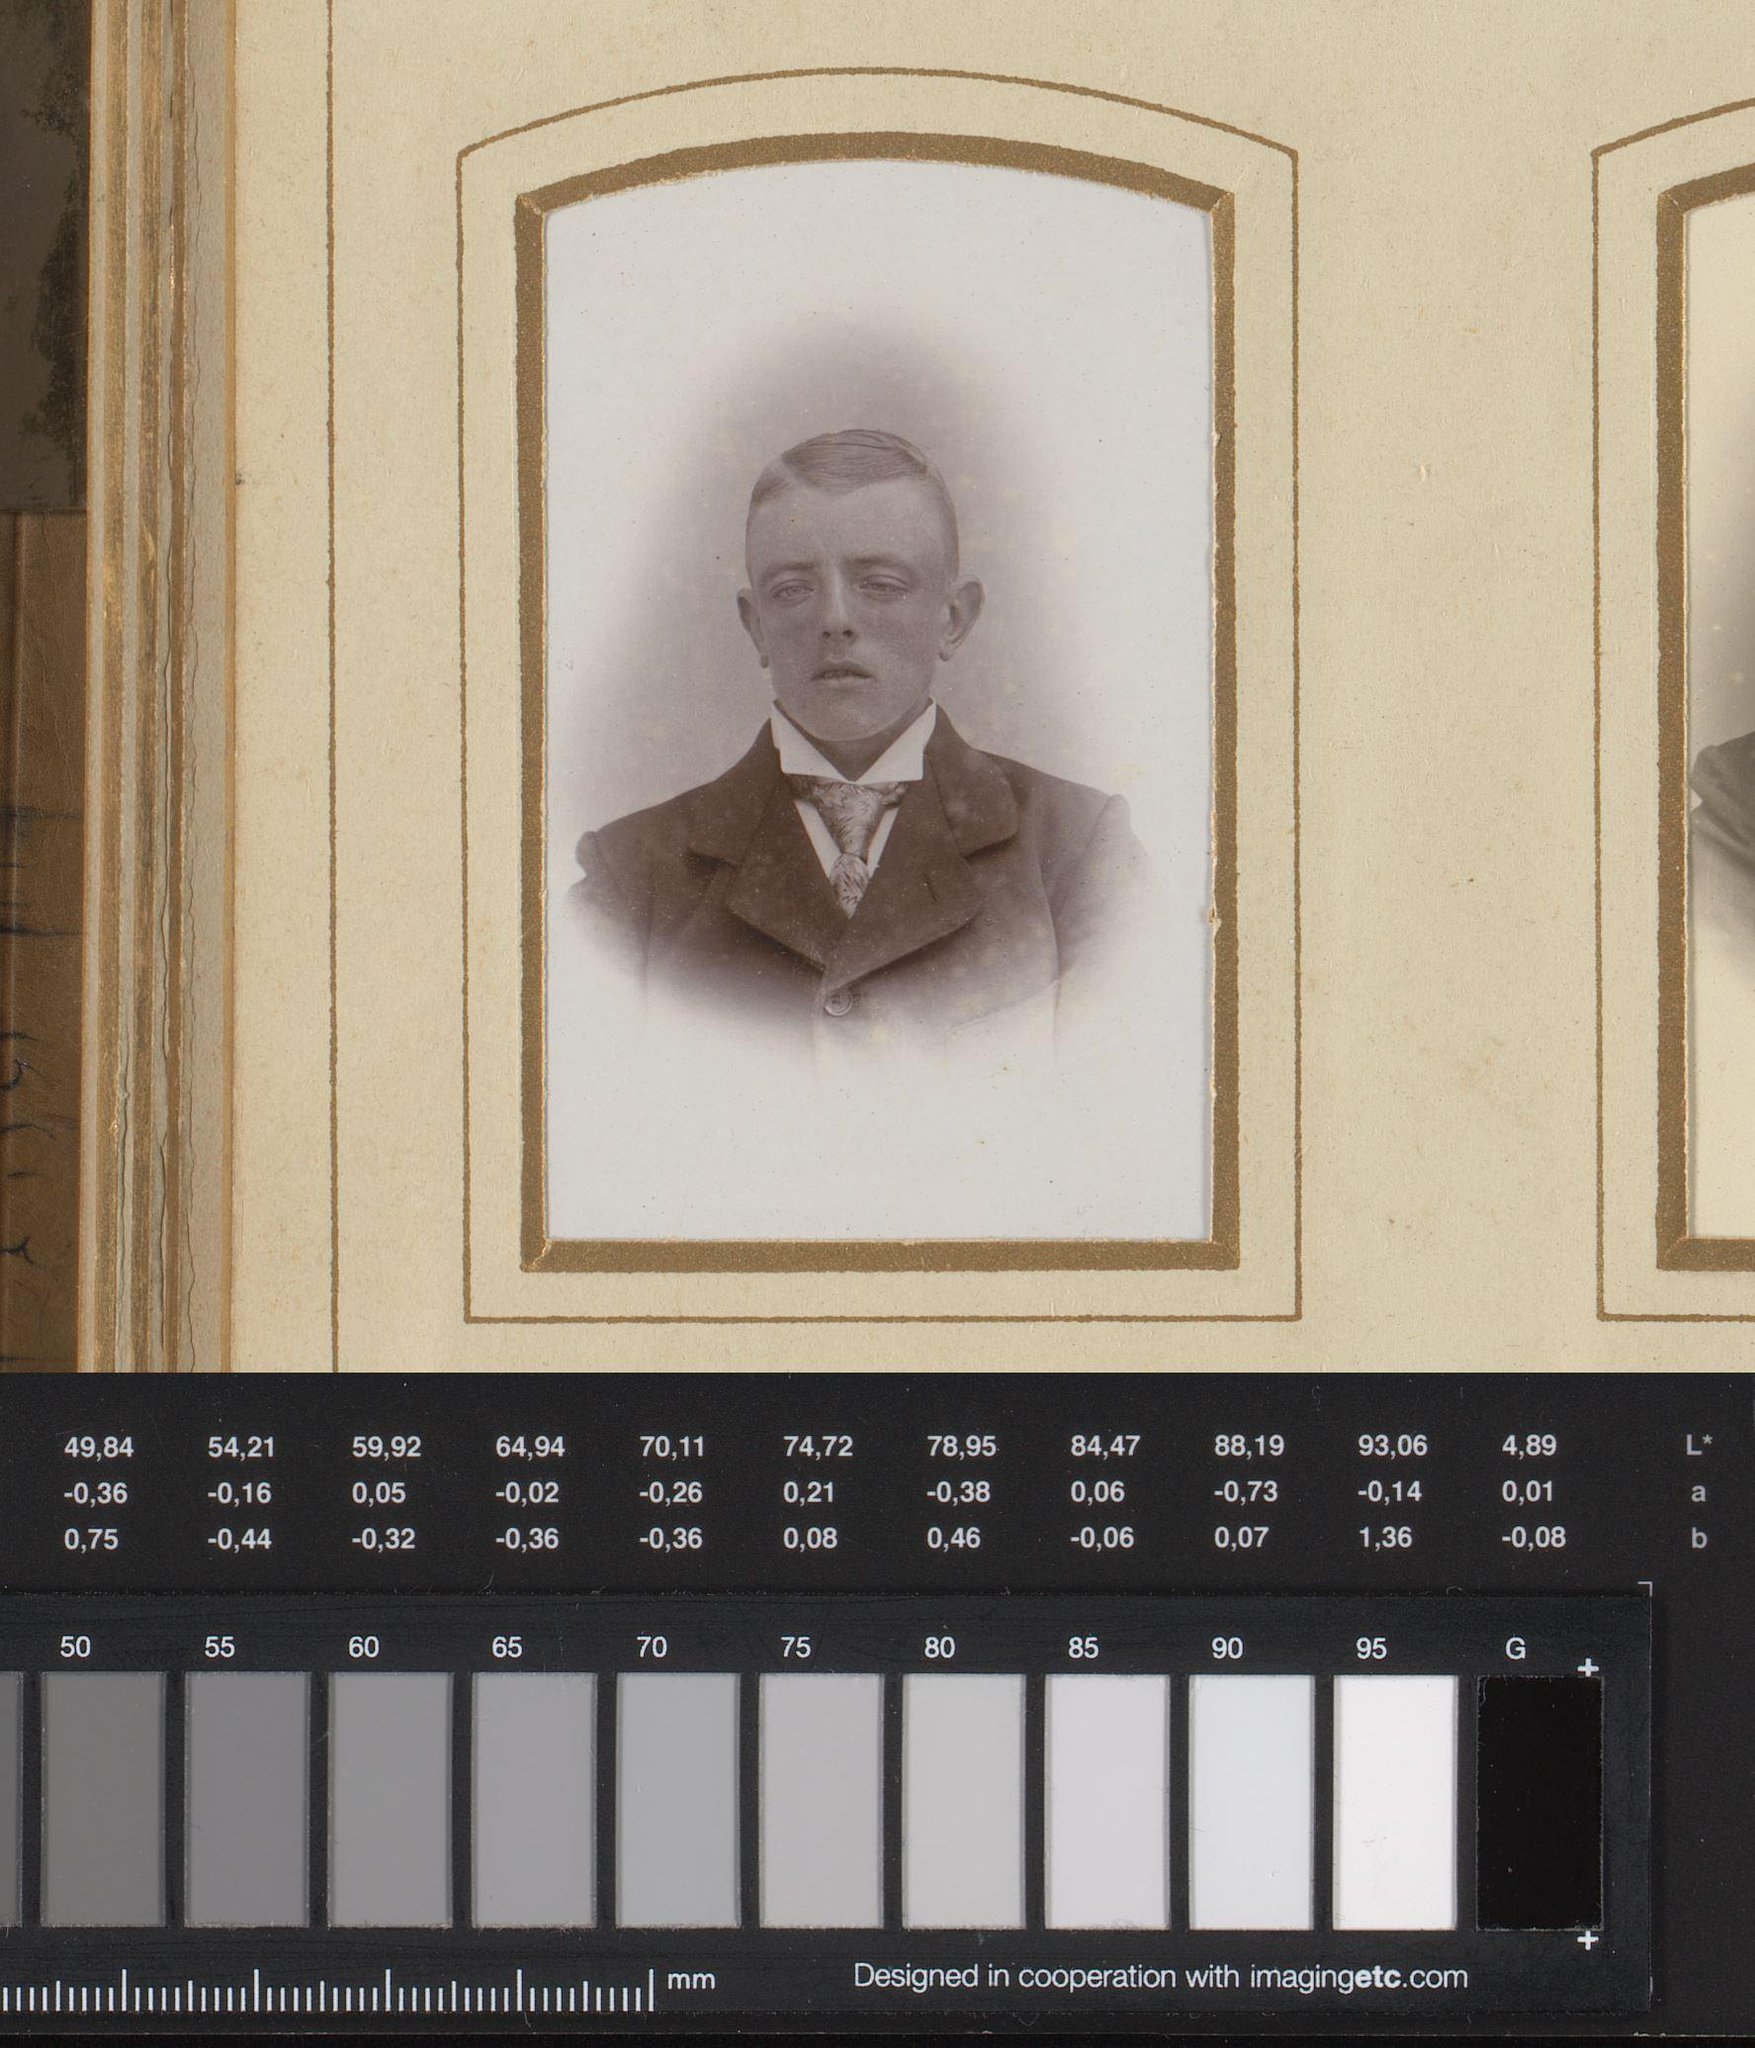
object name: carte de visite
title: Portret van een jonge man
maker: jan ypma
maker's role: fotograaf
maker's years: 1870-1952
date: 1894-1901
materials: cardboard, photographic support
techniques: collodion silver print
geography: edam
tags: historical persons, youth, adolescent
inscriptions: inscription: ‘J. YPMA/ FOTOGRAAF./ EDAM’